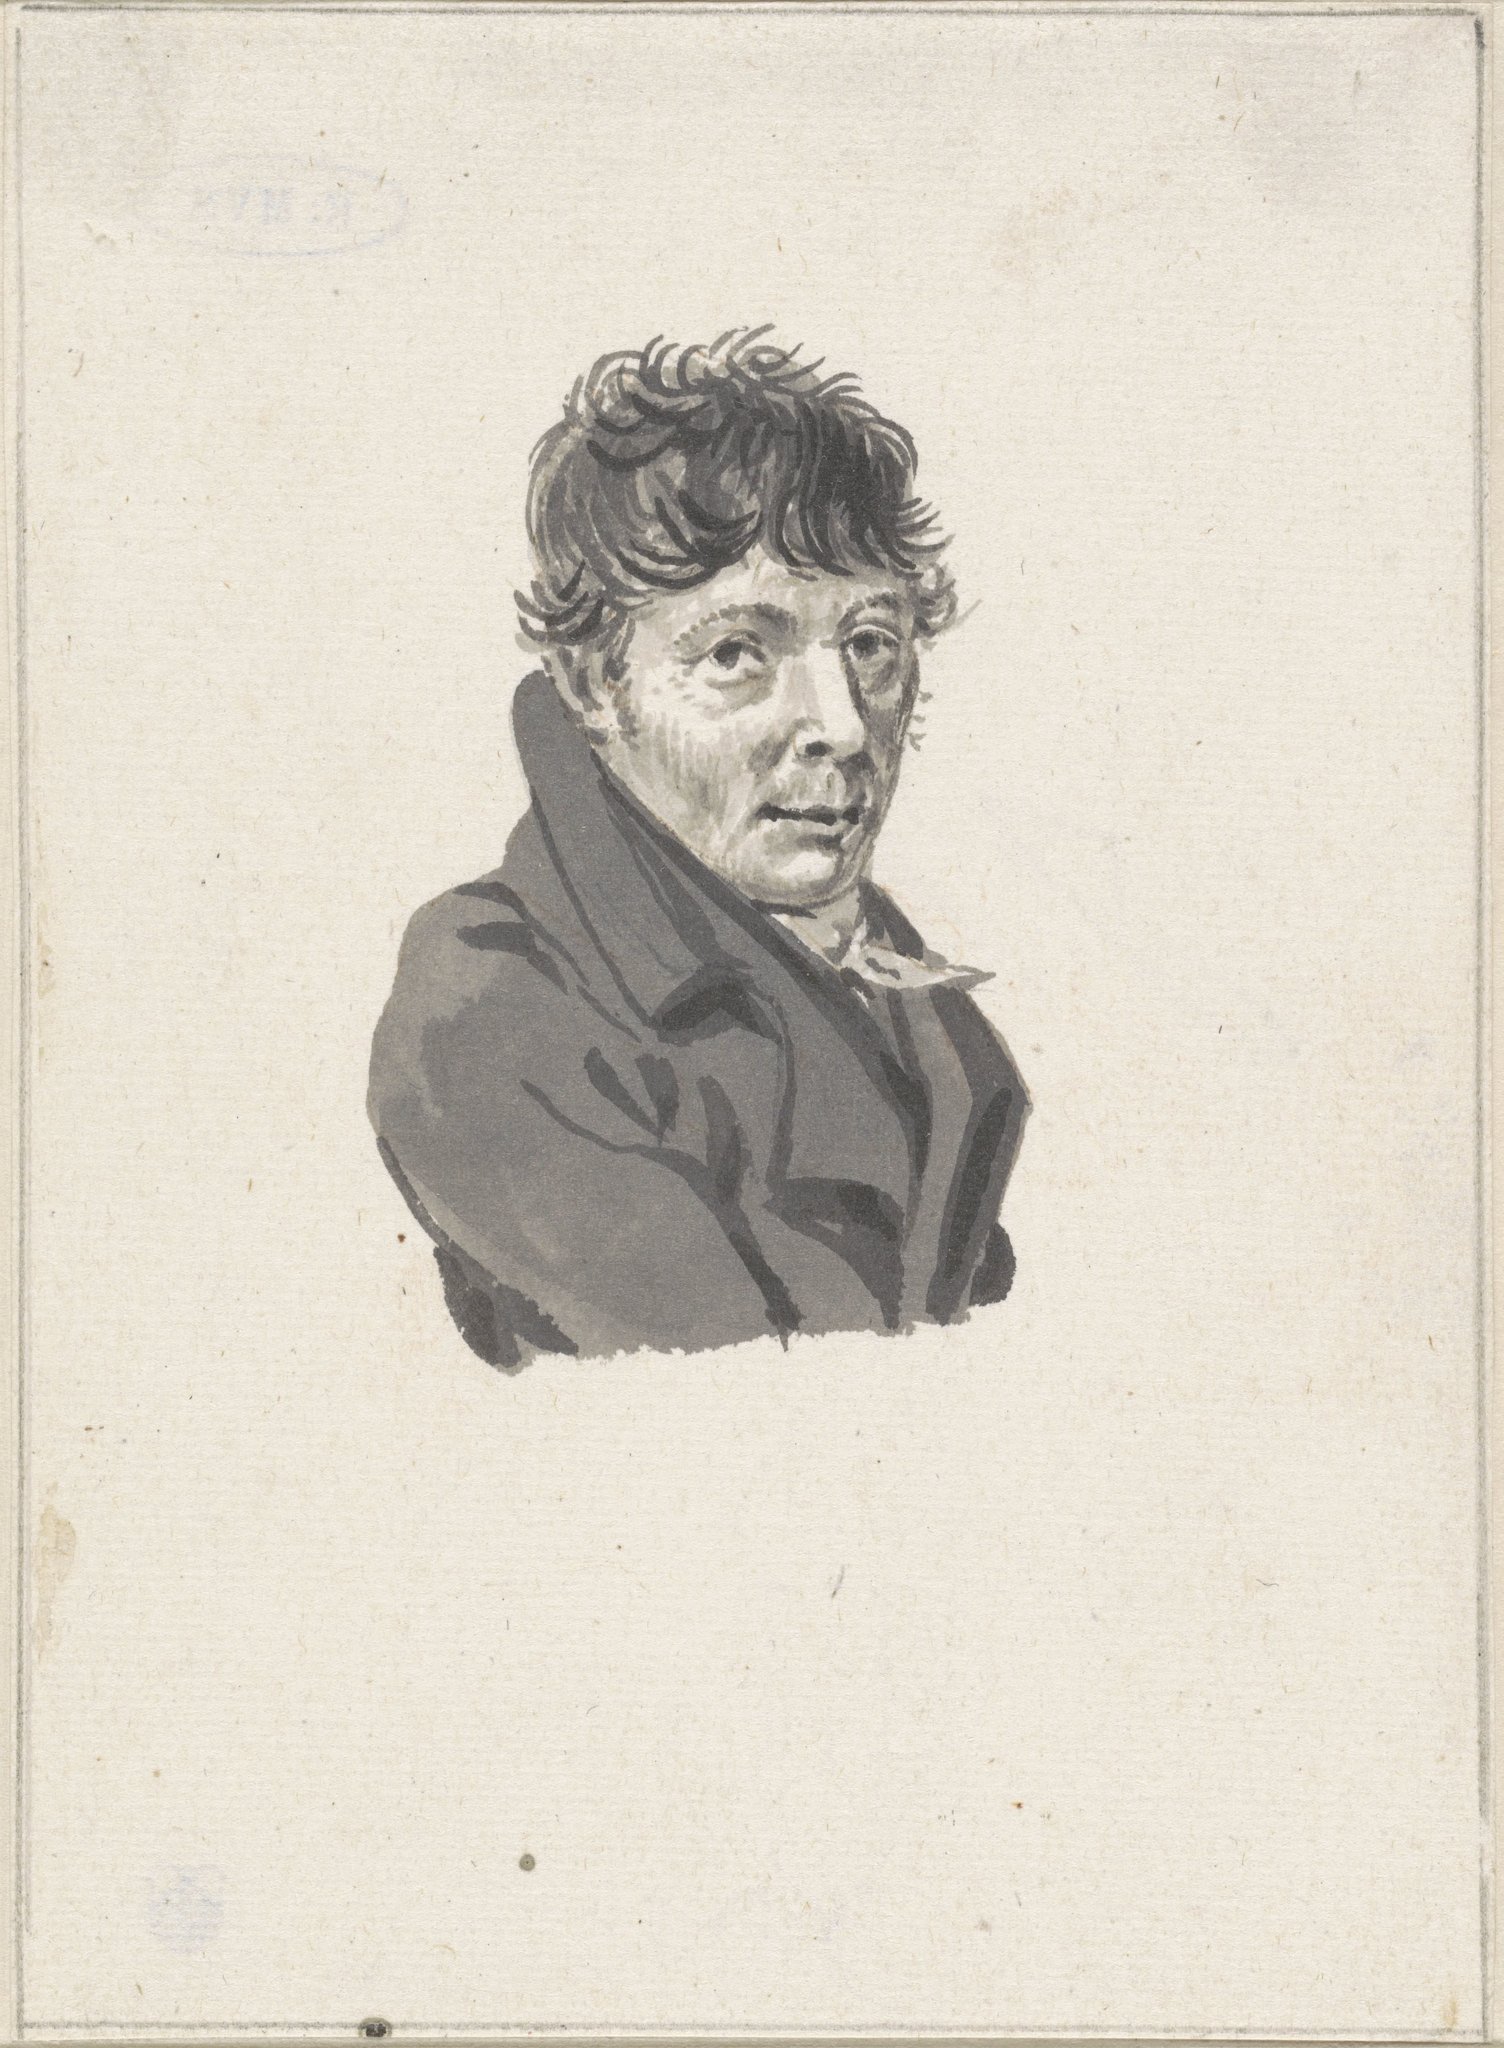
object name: watercolor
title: Portret van Christian Henning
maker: christian henning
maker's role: draughtsman, print maker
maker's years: 1741-1822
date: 1751-1822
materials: paper, watercolor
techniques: brush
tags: zeist, print maker, draughtsman, christian henning, historical persons, portrait, self-portrait of painter, portrait, self-portrait of artist, portrait, self-portrait of draughtsman